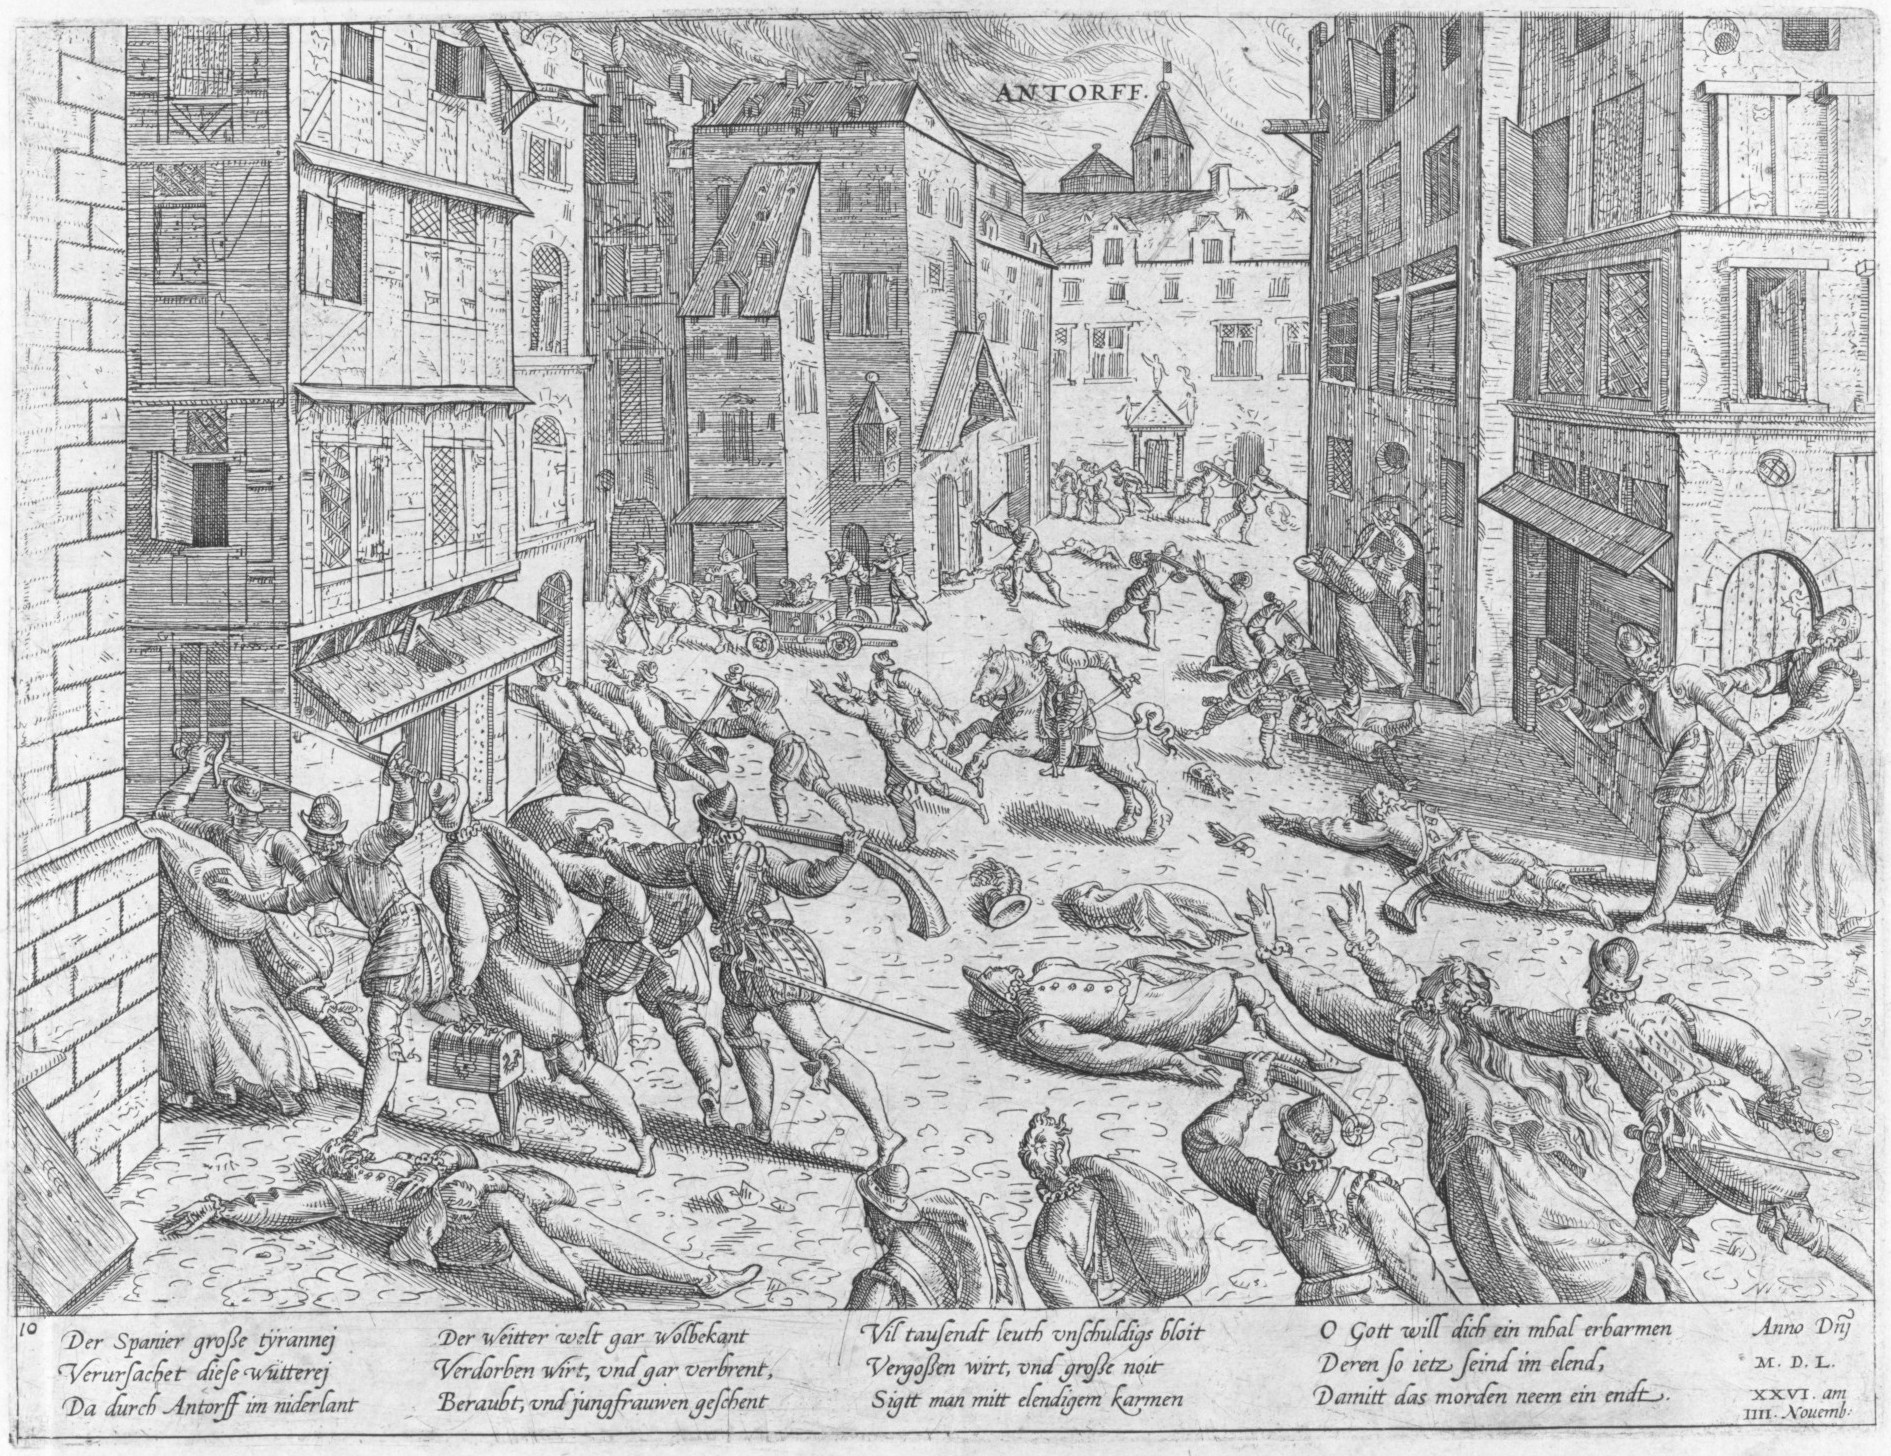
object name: book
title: The Sack of Antwerp from Events in the History of the Netherlands, France, Germany and England between 1533 and 1608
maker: frans hogenberg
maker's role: artist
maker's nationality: netherlandish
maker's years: 1540-1590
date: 1501-1600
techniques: engraving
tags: buildings,streets,battles,soldiers,swords